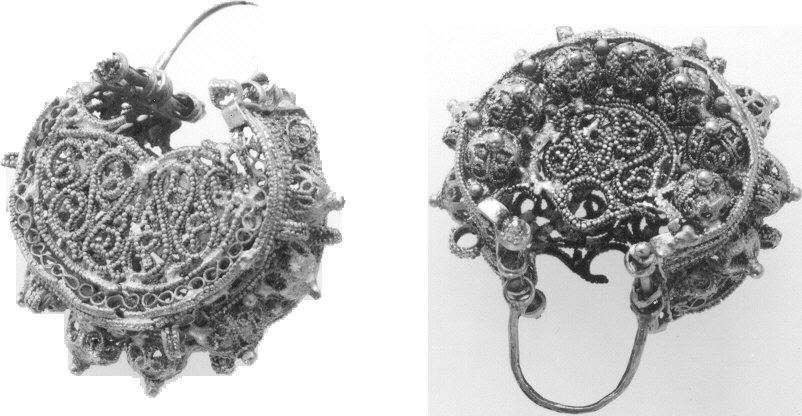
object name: earring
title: Earring, One of a Pair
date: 1001-1100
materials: gold, metal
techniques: filigree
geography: egypt